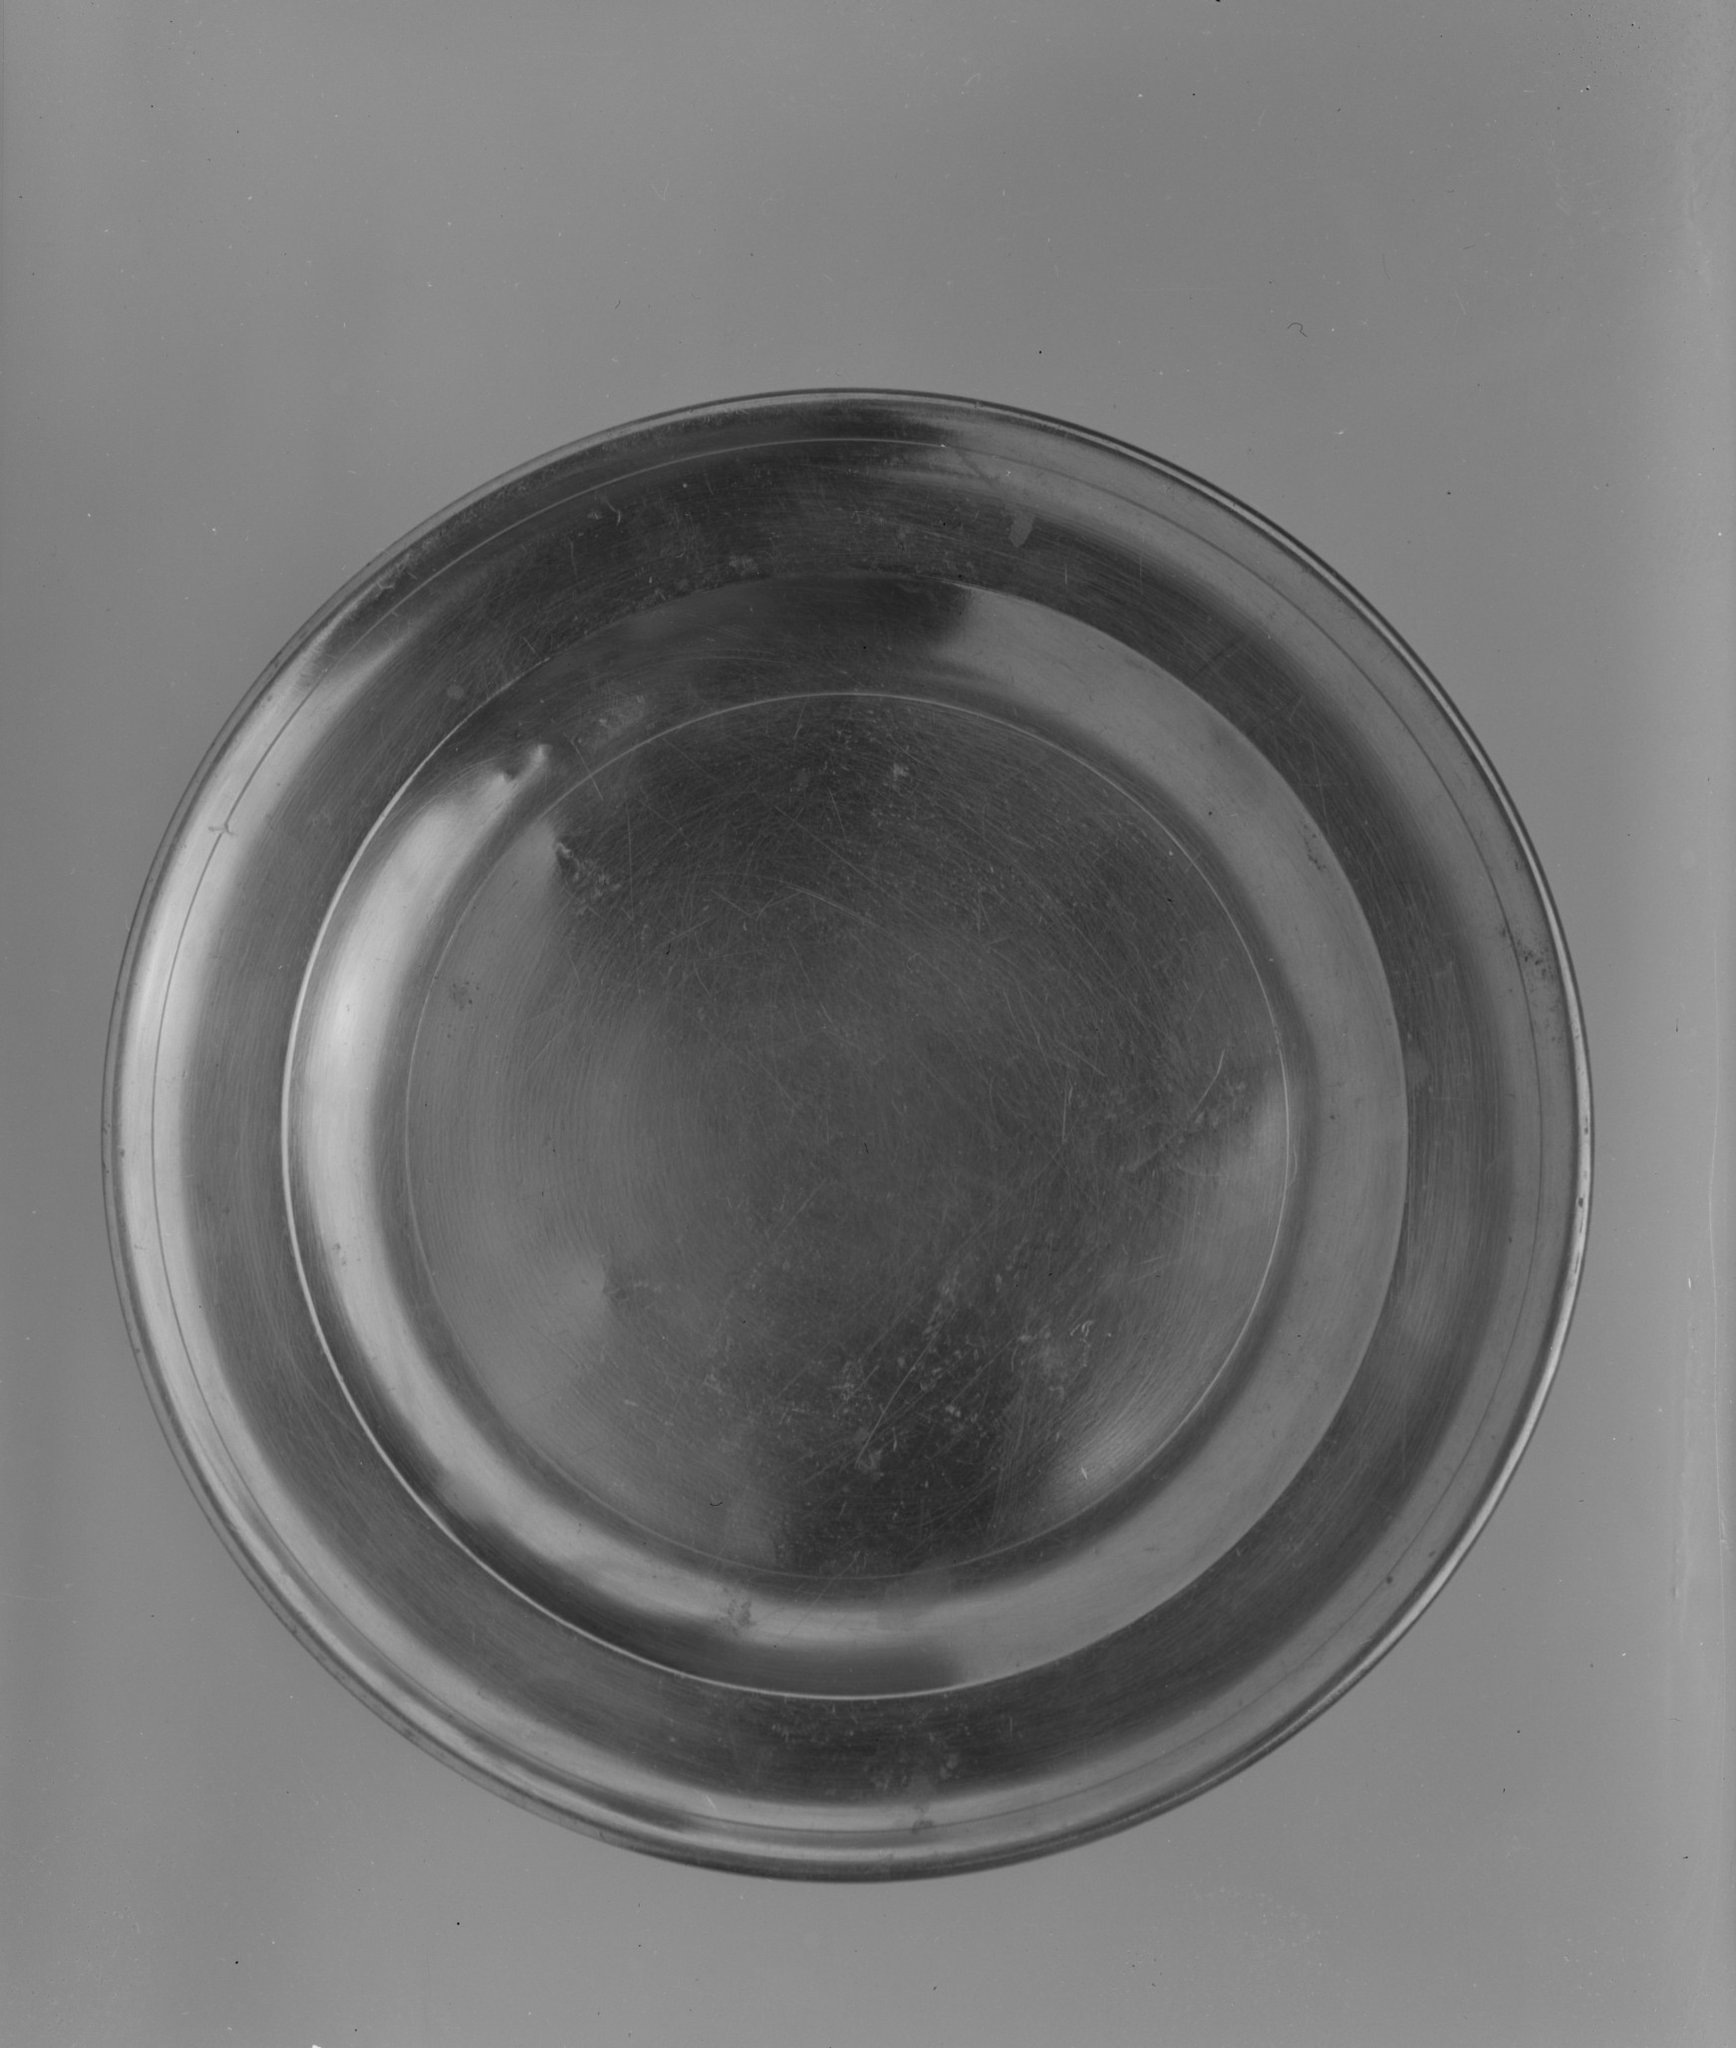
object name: plate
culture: american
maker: henry will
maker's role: maker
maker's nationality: american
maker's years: 1734-1802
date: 1761-1793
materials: pewter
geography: united states